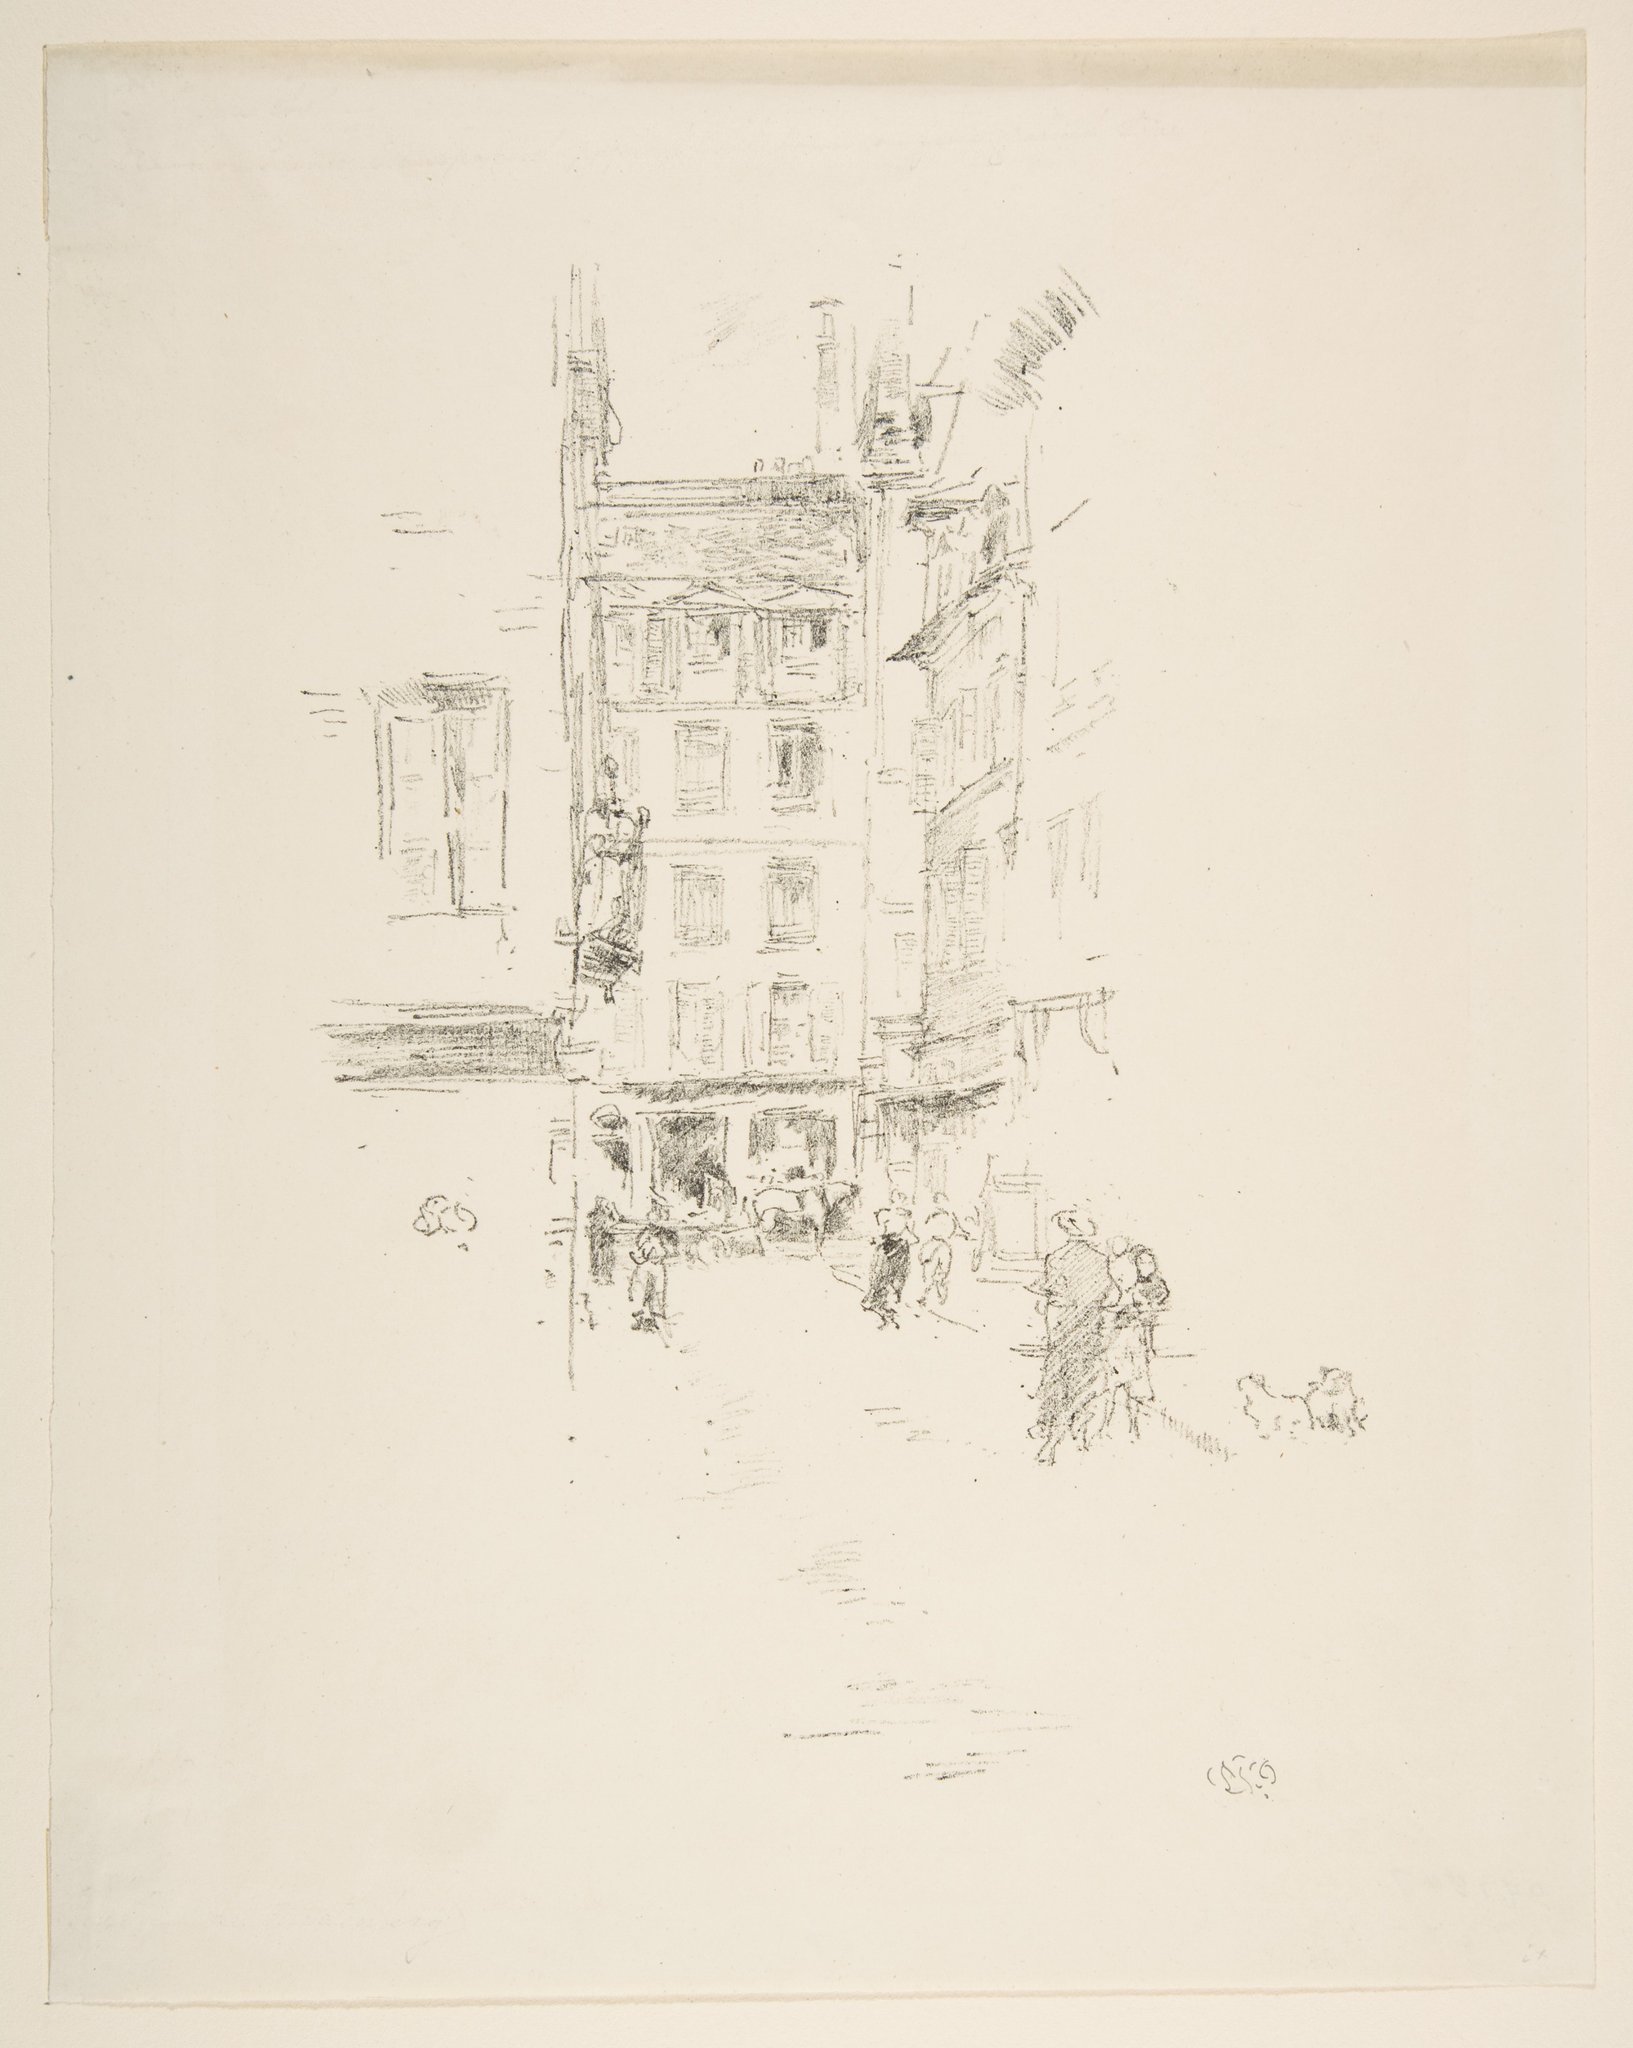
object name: print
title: Rue Furstenburg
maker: james mcneill whistler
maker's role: artist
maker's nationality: american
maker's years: 1834-1903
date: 1894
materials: ink, paper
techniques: printing, lithography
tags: buildings